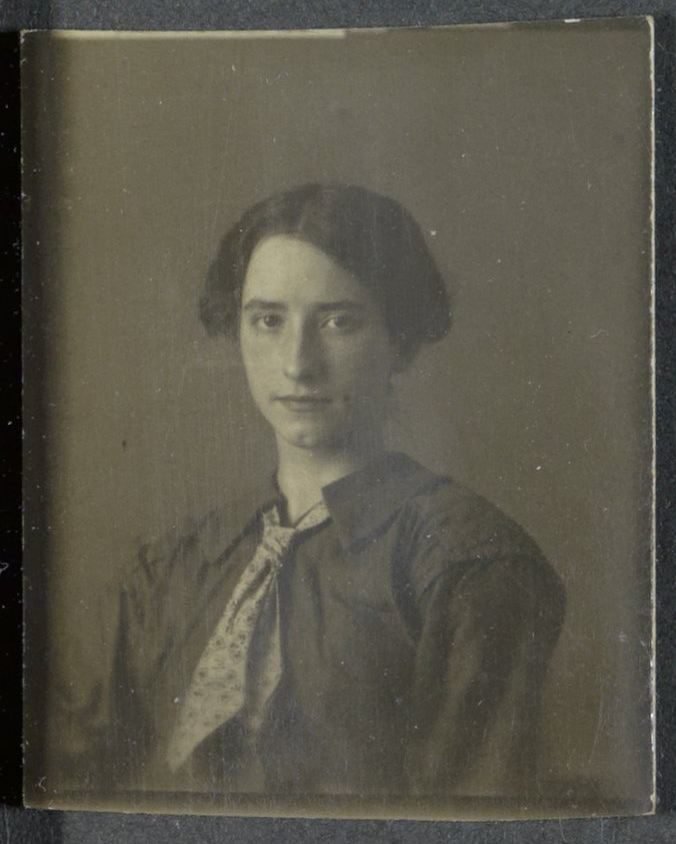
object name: album leaf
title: Portret van een vrouw met opgebonden haar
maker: Anonymous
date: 1920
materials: cardboard, paper, photographic support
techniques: gelatin silver print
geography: netherlands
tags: adult woman, historical persons, styles of hairdress - aa - ~ women, netherlands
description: Onderdeel van Fotoalbum met portretten vervaardigd door Nederlandse studio's waaronder automaatfoto's.